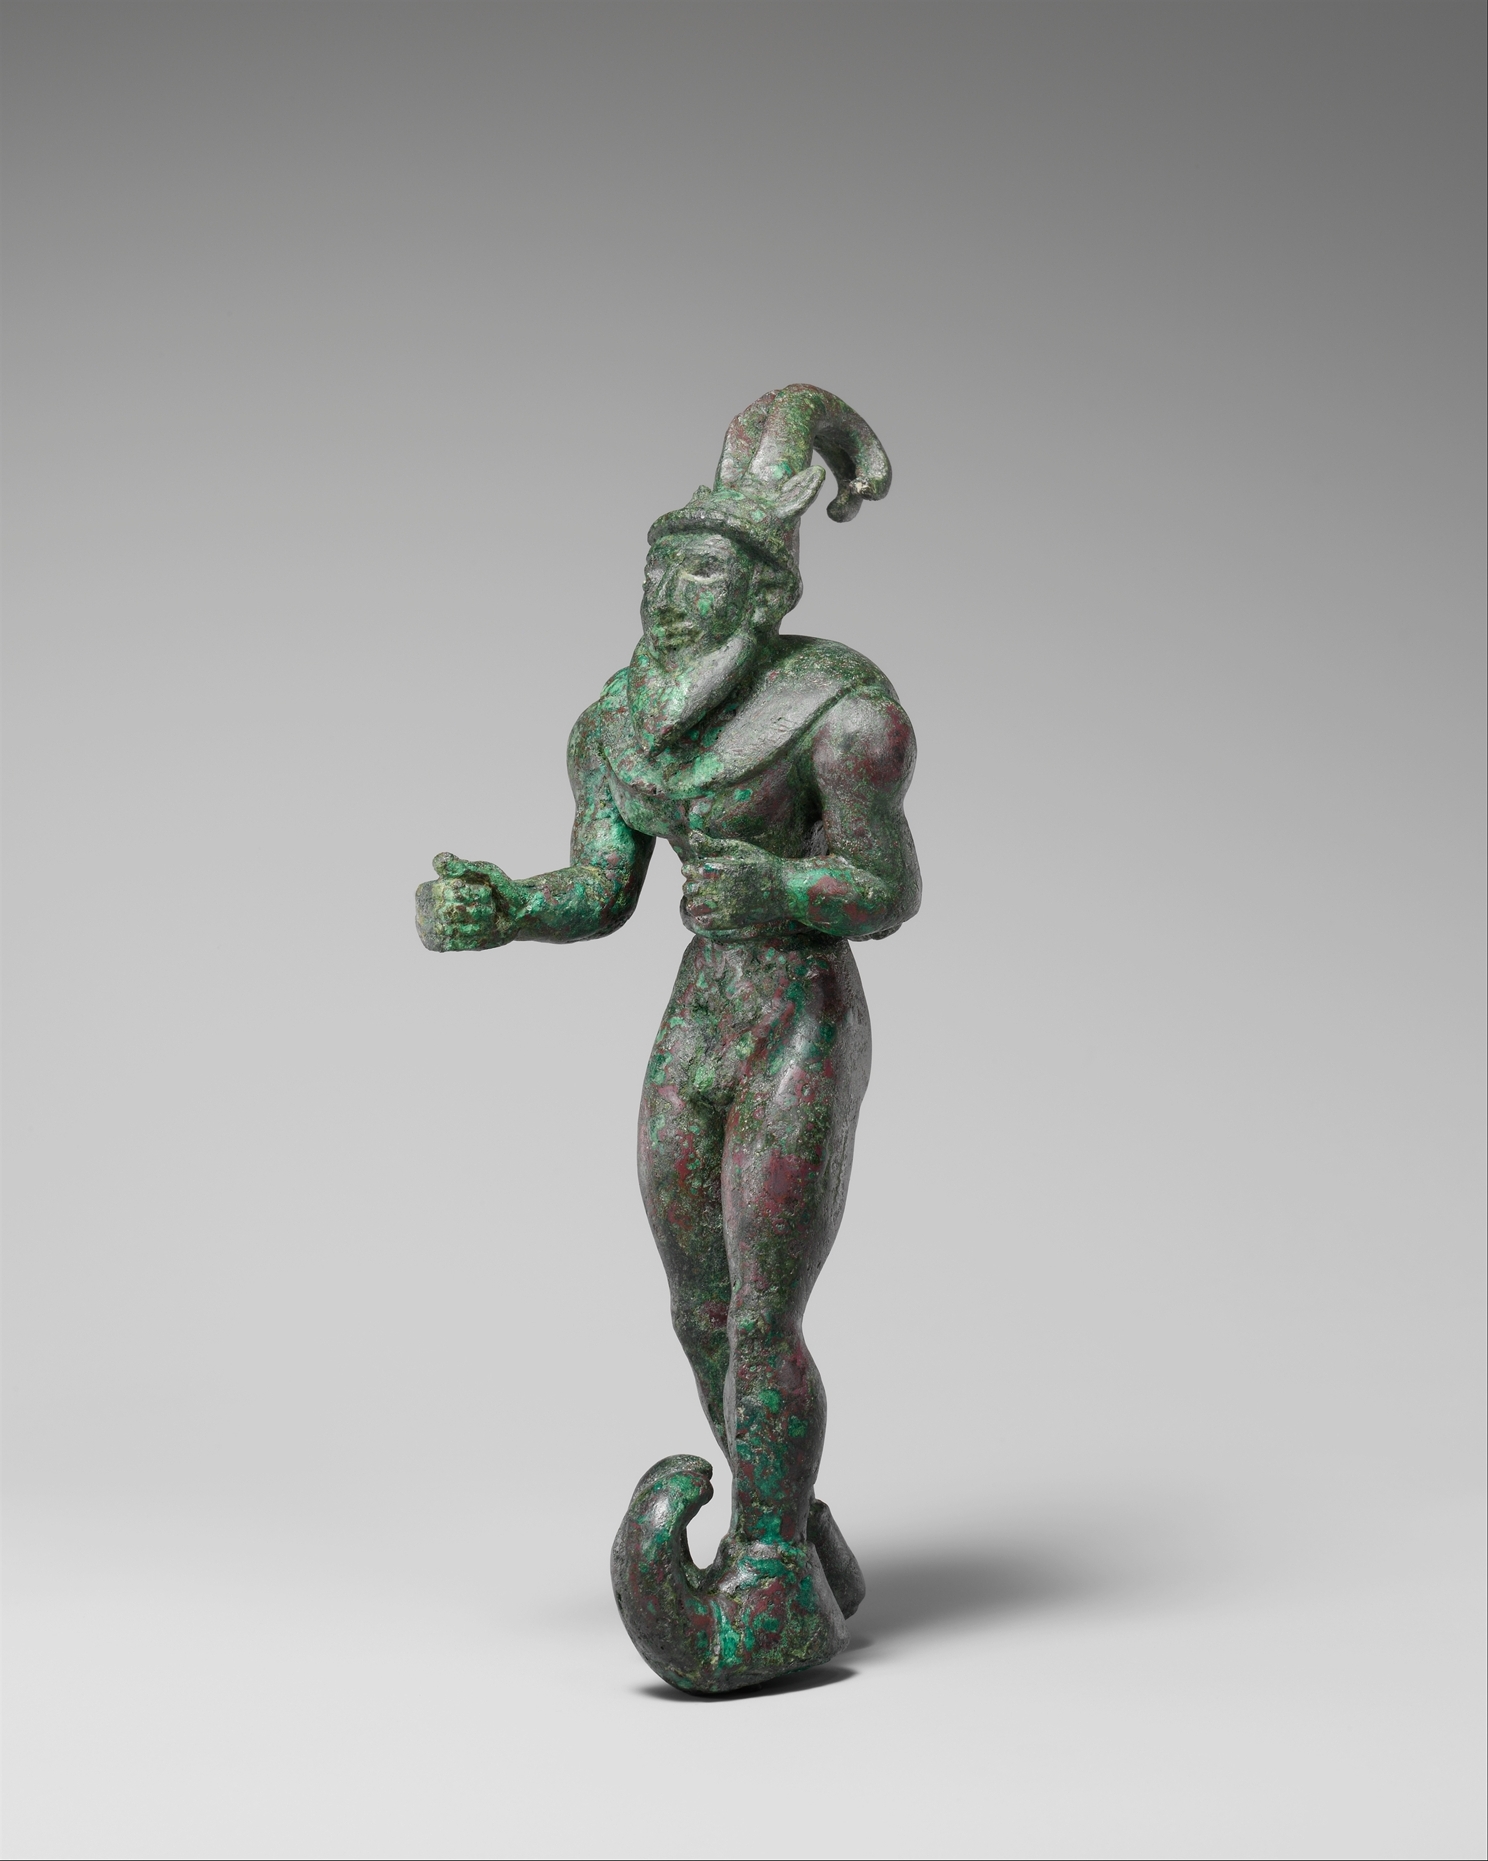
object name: sculpture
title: Striding figure with ibex horns, a raptor skin draped around the shoulders, and upturned boots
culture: proto-elamite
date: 3000 BCE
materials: copper alloy, shell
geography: mesopotamia or iran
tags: men